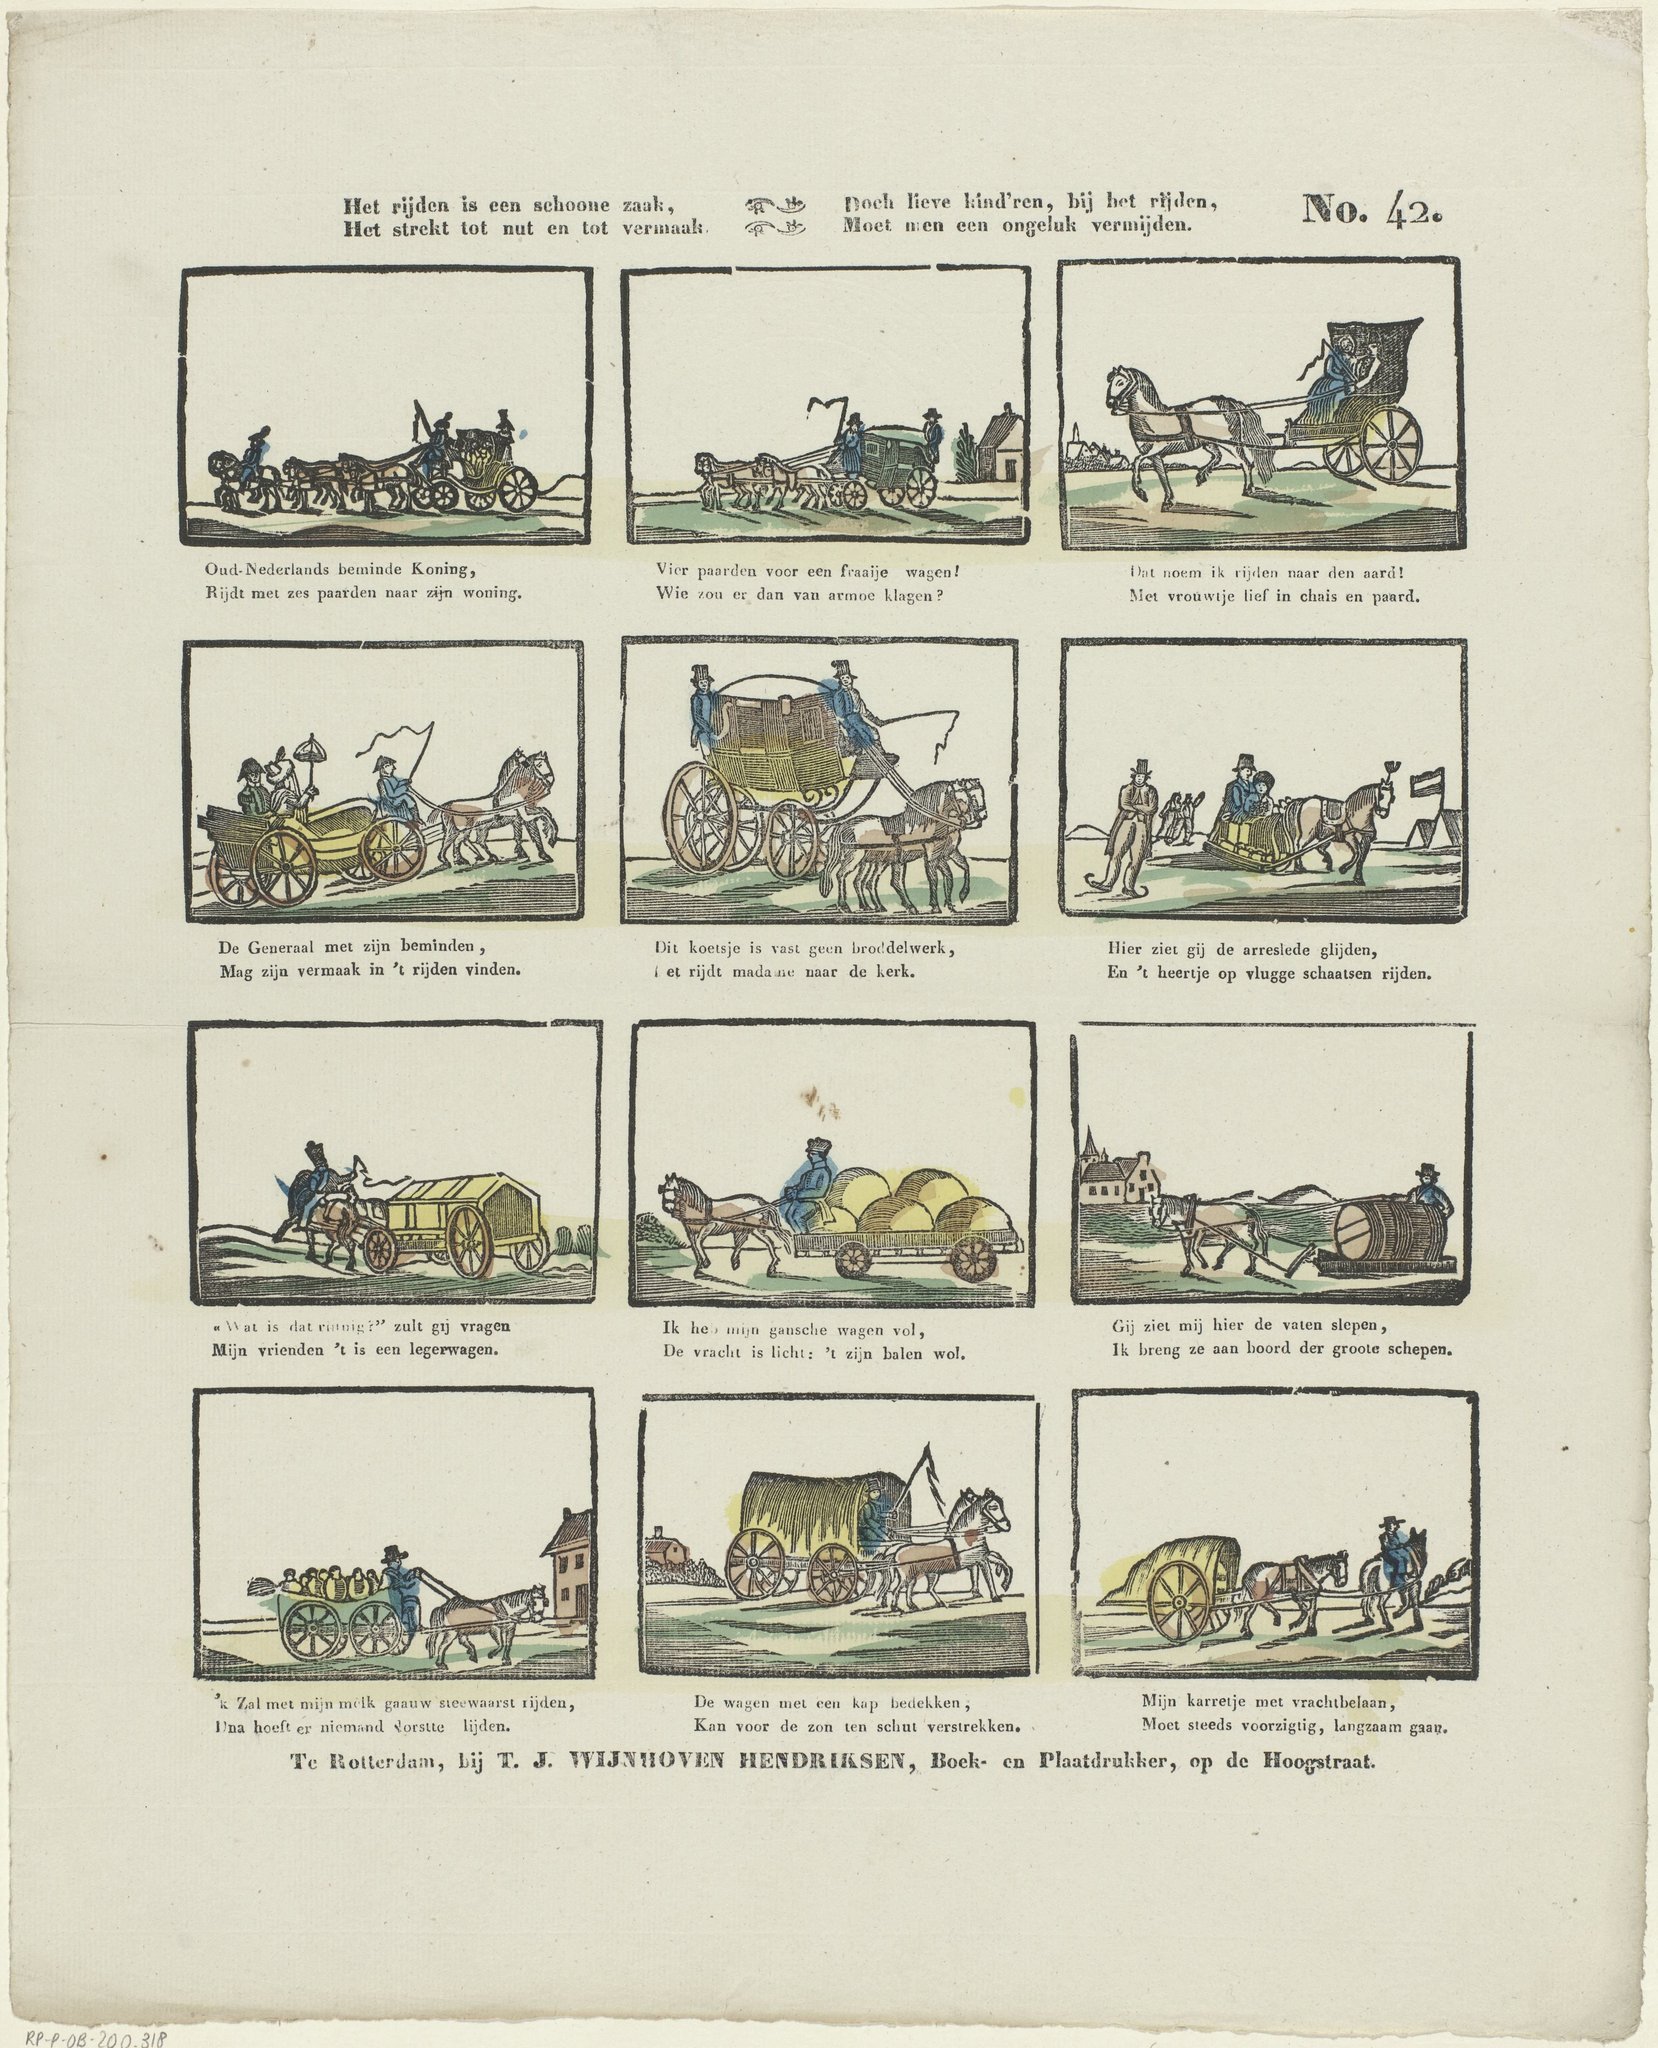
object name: popular print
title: Het rijden is een schoone zaak, / Het strekt tot nut en tot vermaak / Doch lieve kind'ren, bij het rijden, / Moet men een ongeluk vermijden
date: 1832-1850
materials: paper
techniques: colour, letterpress printing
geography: rotterdam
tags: four-wheeled, animal-drawn vehicle, e.g.: cab, carriage, coach, two-wheeled vehicle drawn by two animals, two-wheeled vehicle drawn by one animal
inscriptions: collector's mark: Lugt 2760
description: Blad met 12 voorstellingen van koetsen, karren en wagens met personen en vracht, getrokken door paarden. Onder elke afbeelding een tweeregelig vers. Genummerd rechtsboven: No. 42.